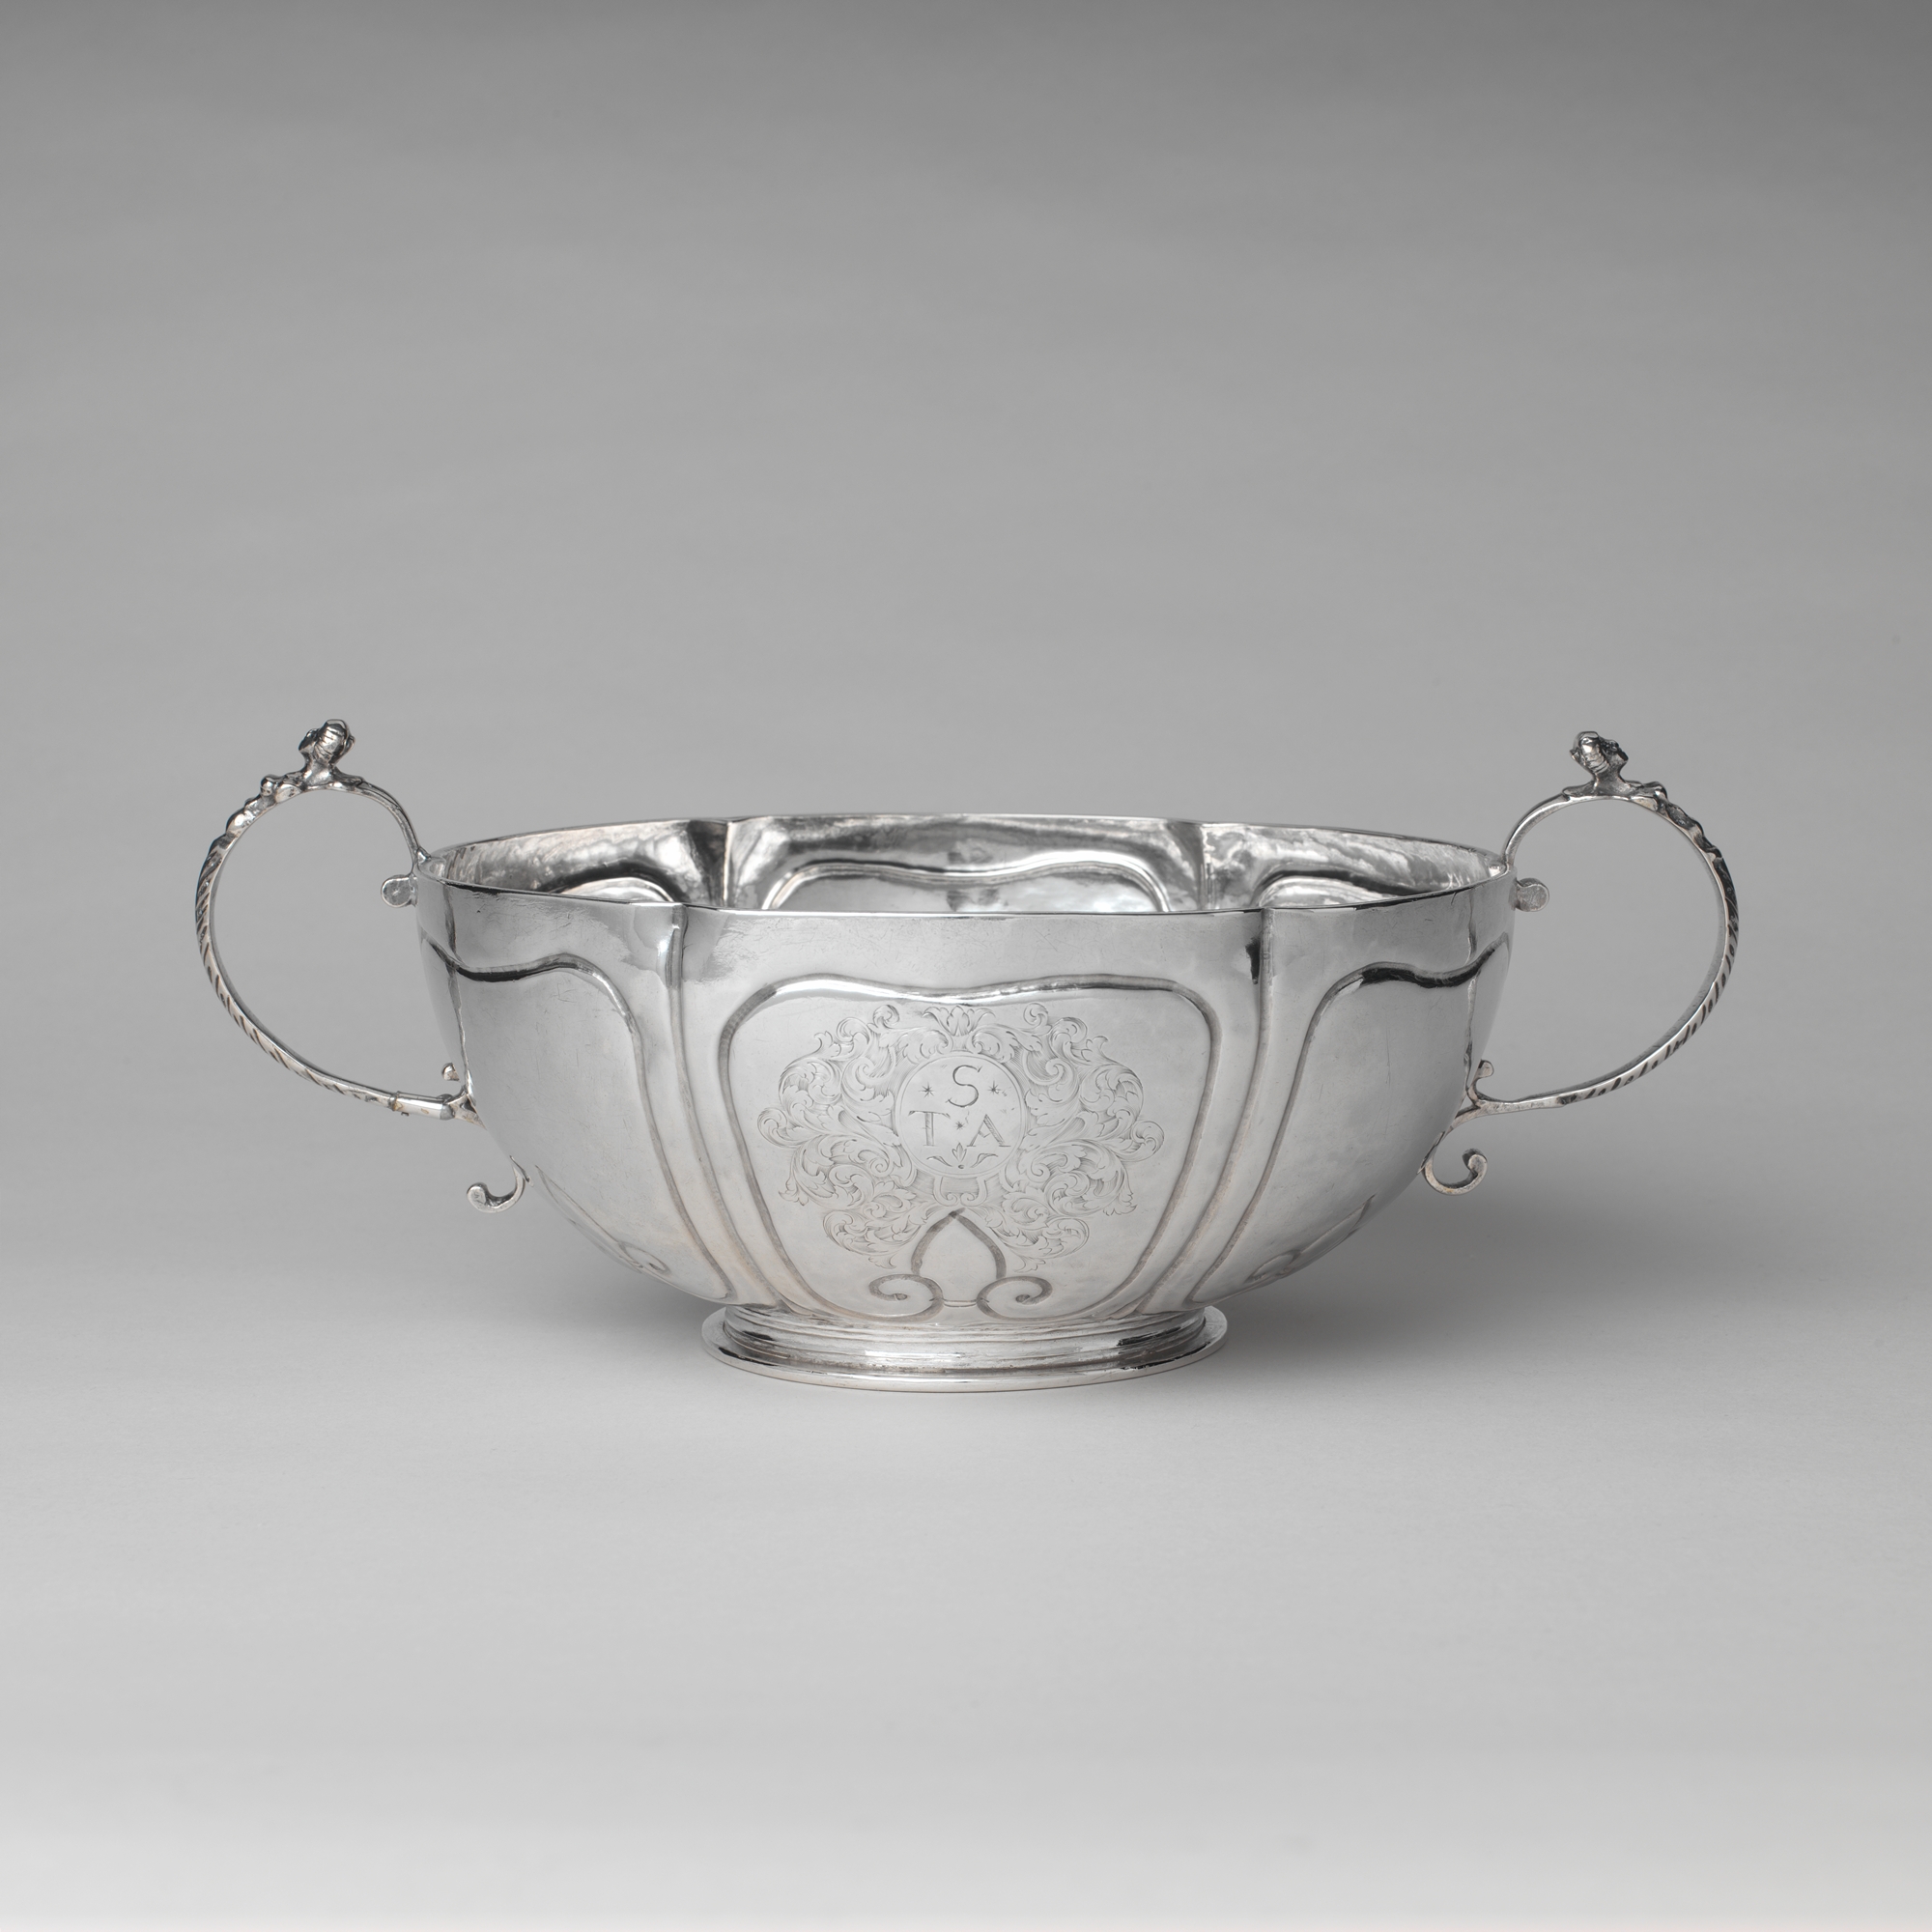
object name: two handled bowl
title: Two-handled bowl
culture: american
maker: jesse kip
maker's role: maker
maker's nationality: american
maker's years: 1660-1722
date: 1690-1710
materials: silver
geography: united states